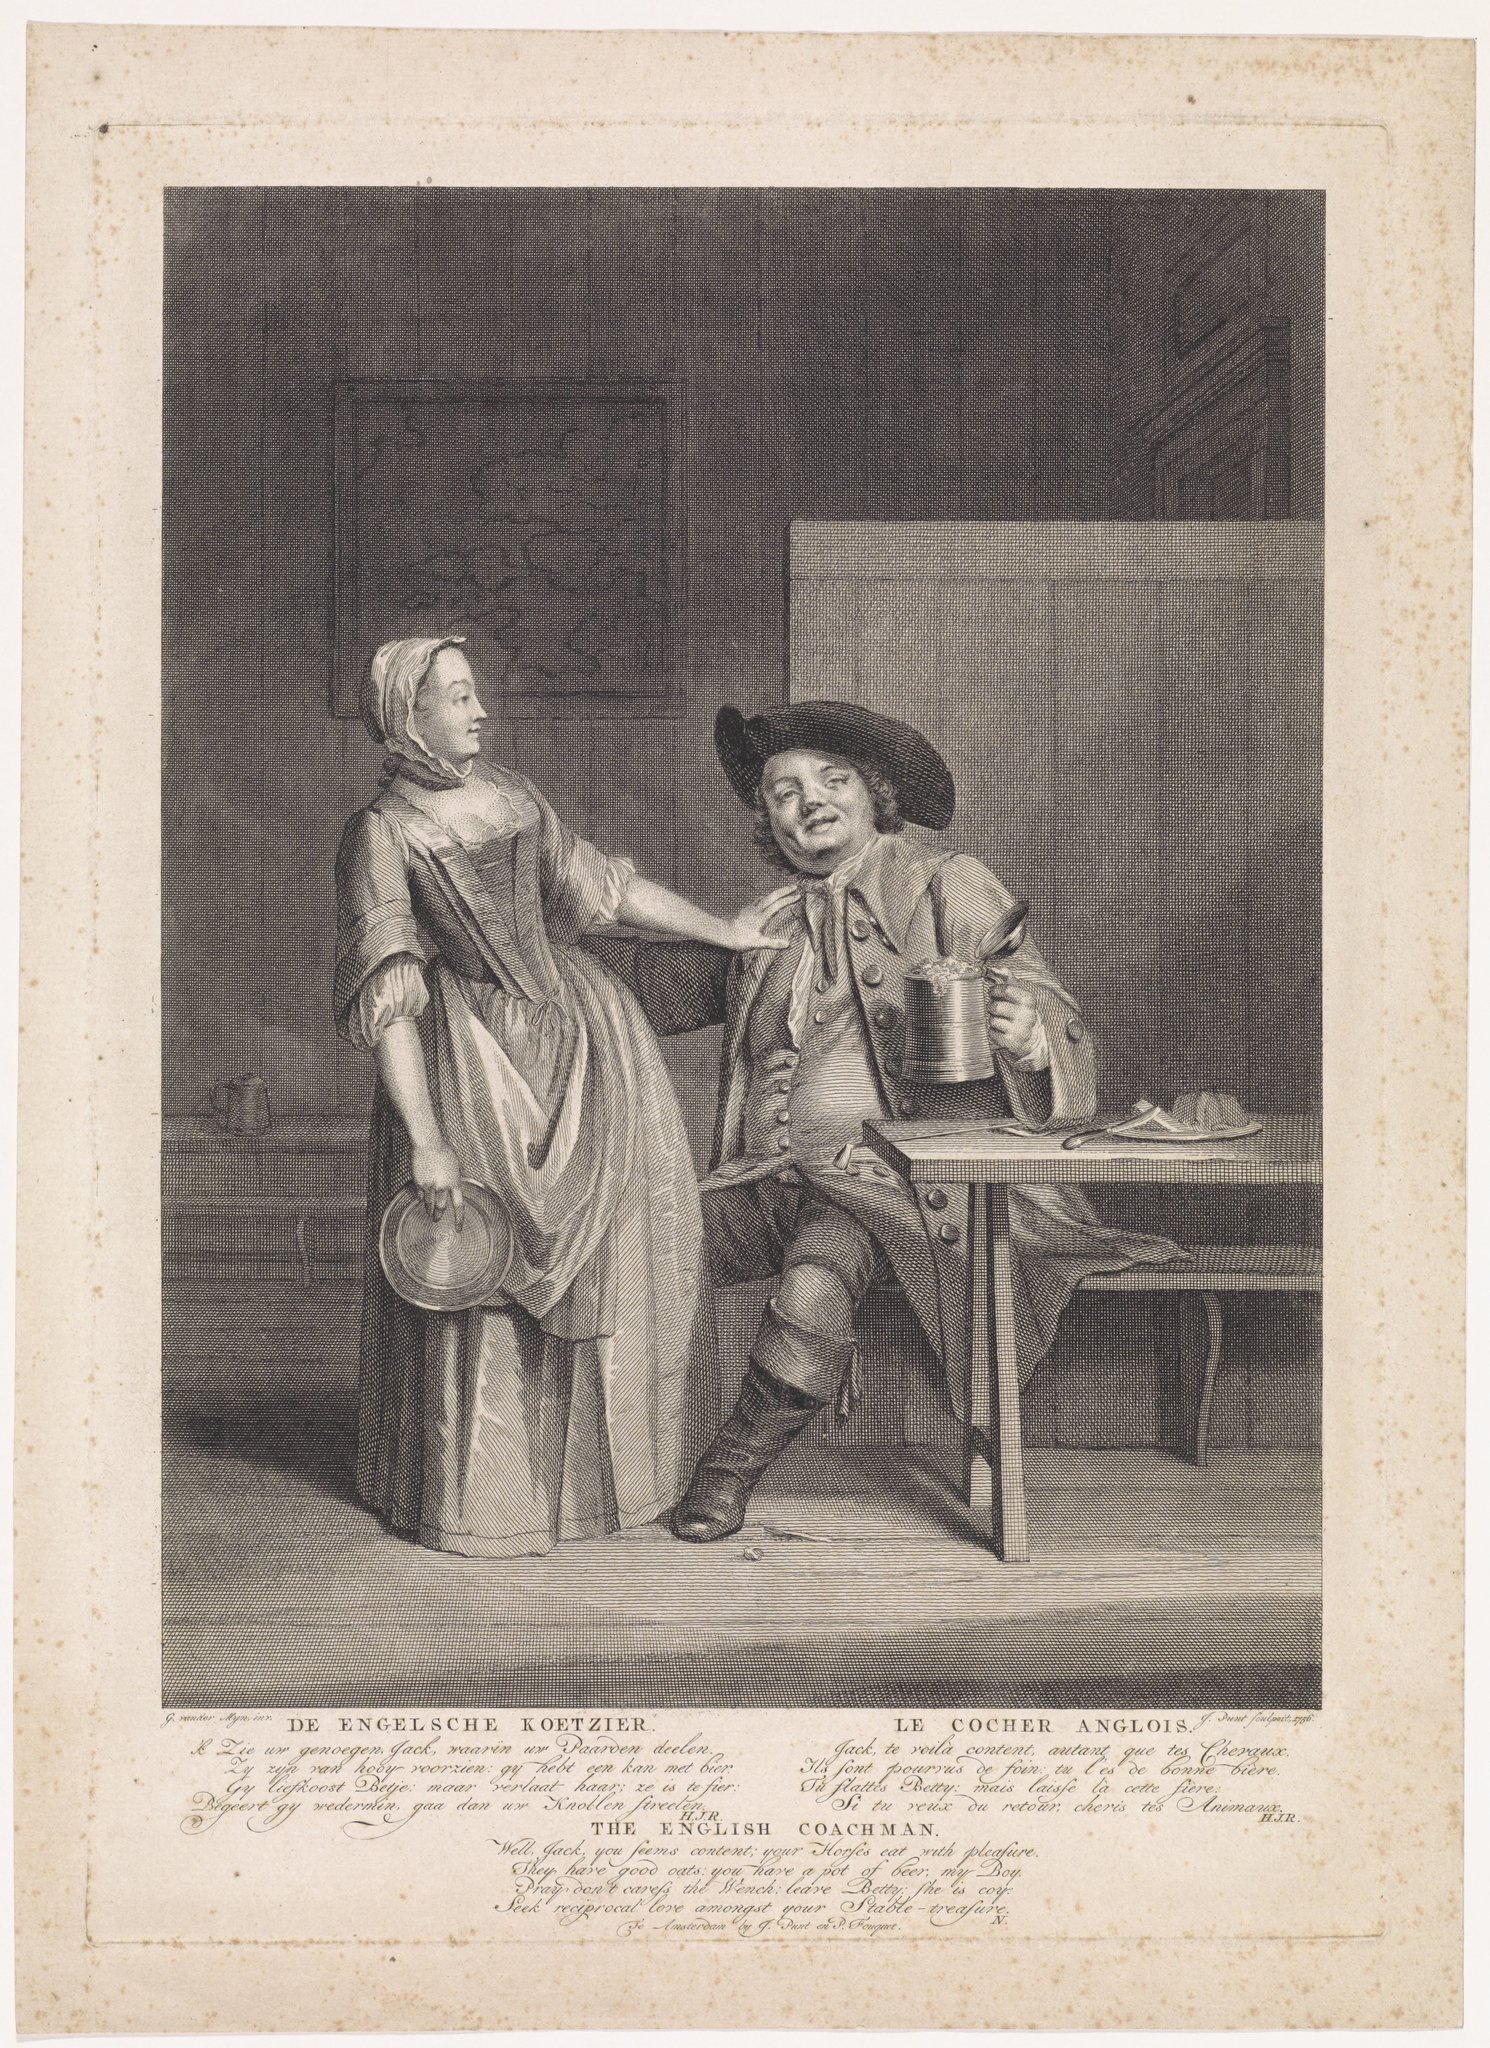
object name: print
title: De Engelsche Koetzier / Le Cocher Anglois / The English Coachman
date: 1756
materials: paper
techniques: engraving, etching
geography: amsterdam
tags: inn, coffee-house, public house, etc., unsuccessful love affair; seduction, beer, ale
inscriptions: collector's mark: Lugt 2228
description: Een koetsier zit een een tafel in een herberg, met een grote kan bier in zijn hand. Hij probeert de waardin te verleiden, maar zij houdt hem af. In de marge een vierregelig satirisch vers in het Nederlands, Frans en Engels.